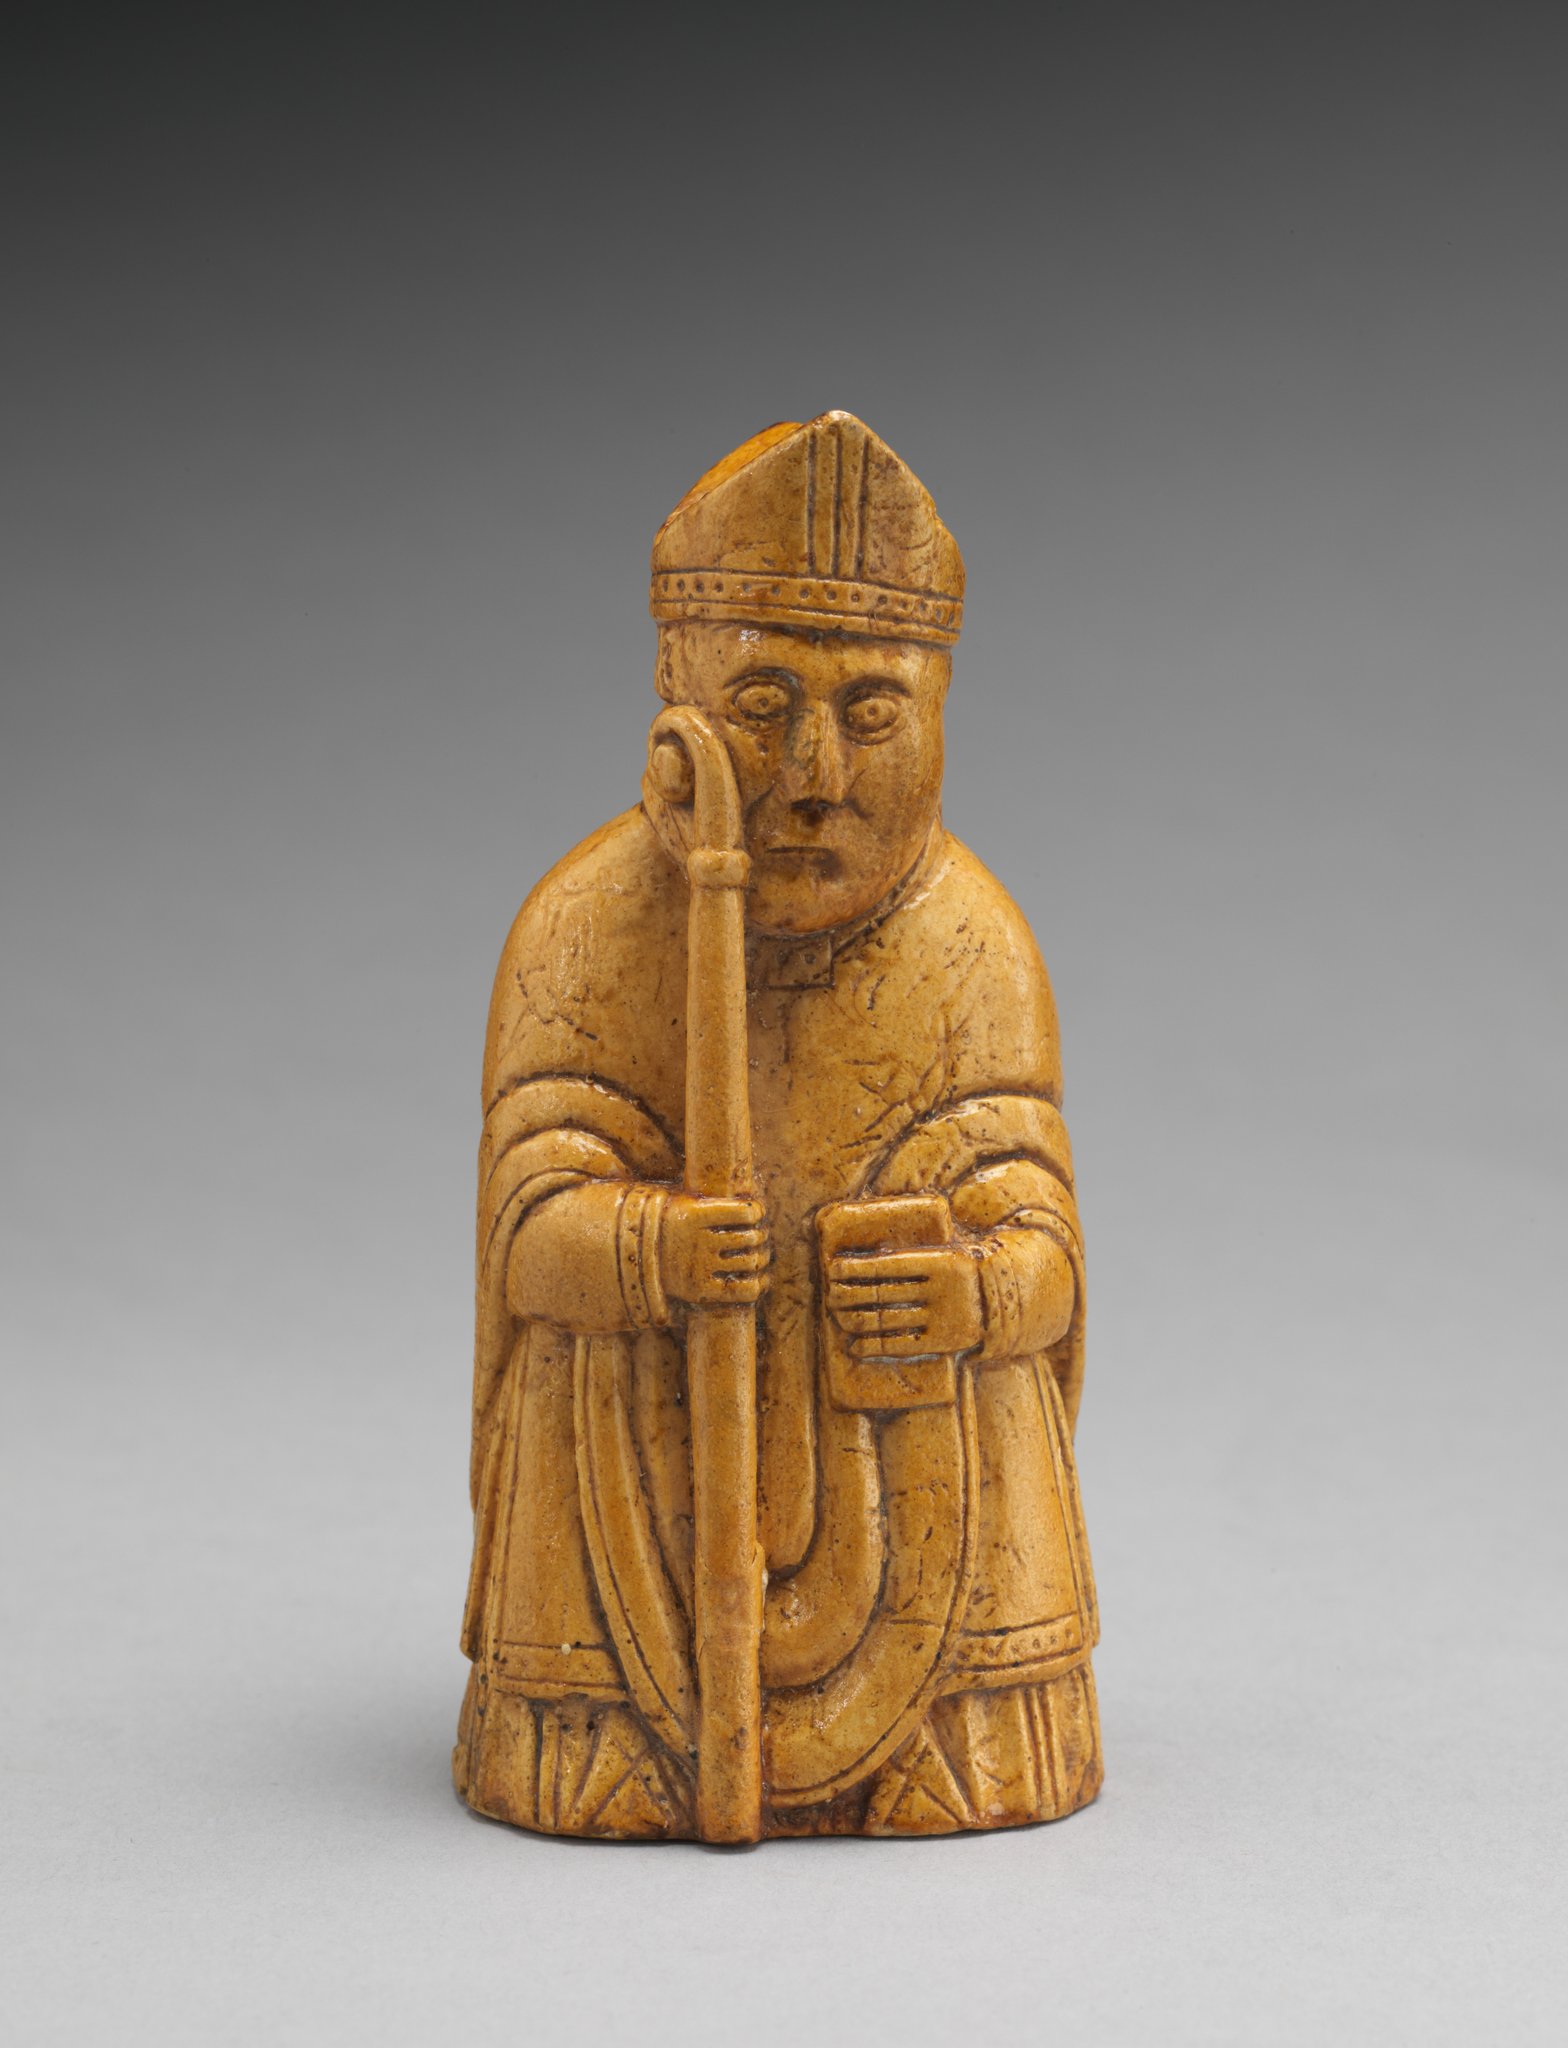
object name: chessman bishop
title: Chessman (Bishop)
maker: elkington & co.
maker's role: manufacturer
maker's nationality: british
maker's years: 1829-1963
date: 1870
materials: ivory, plaster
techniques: painting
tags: chess,bishops